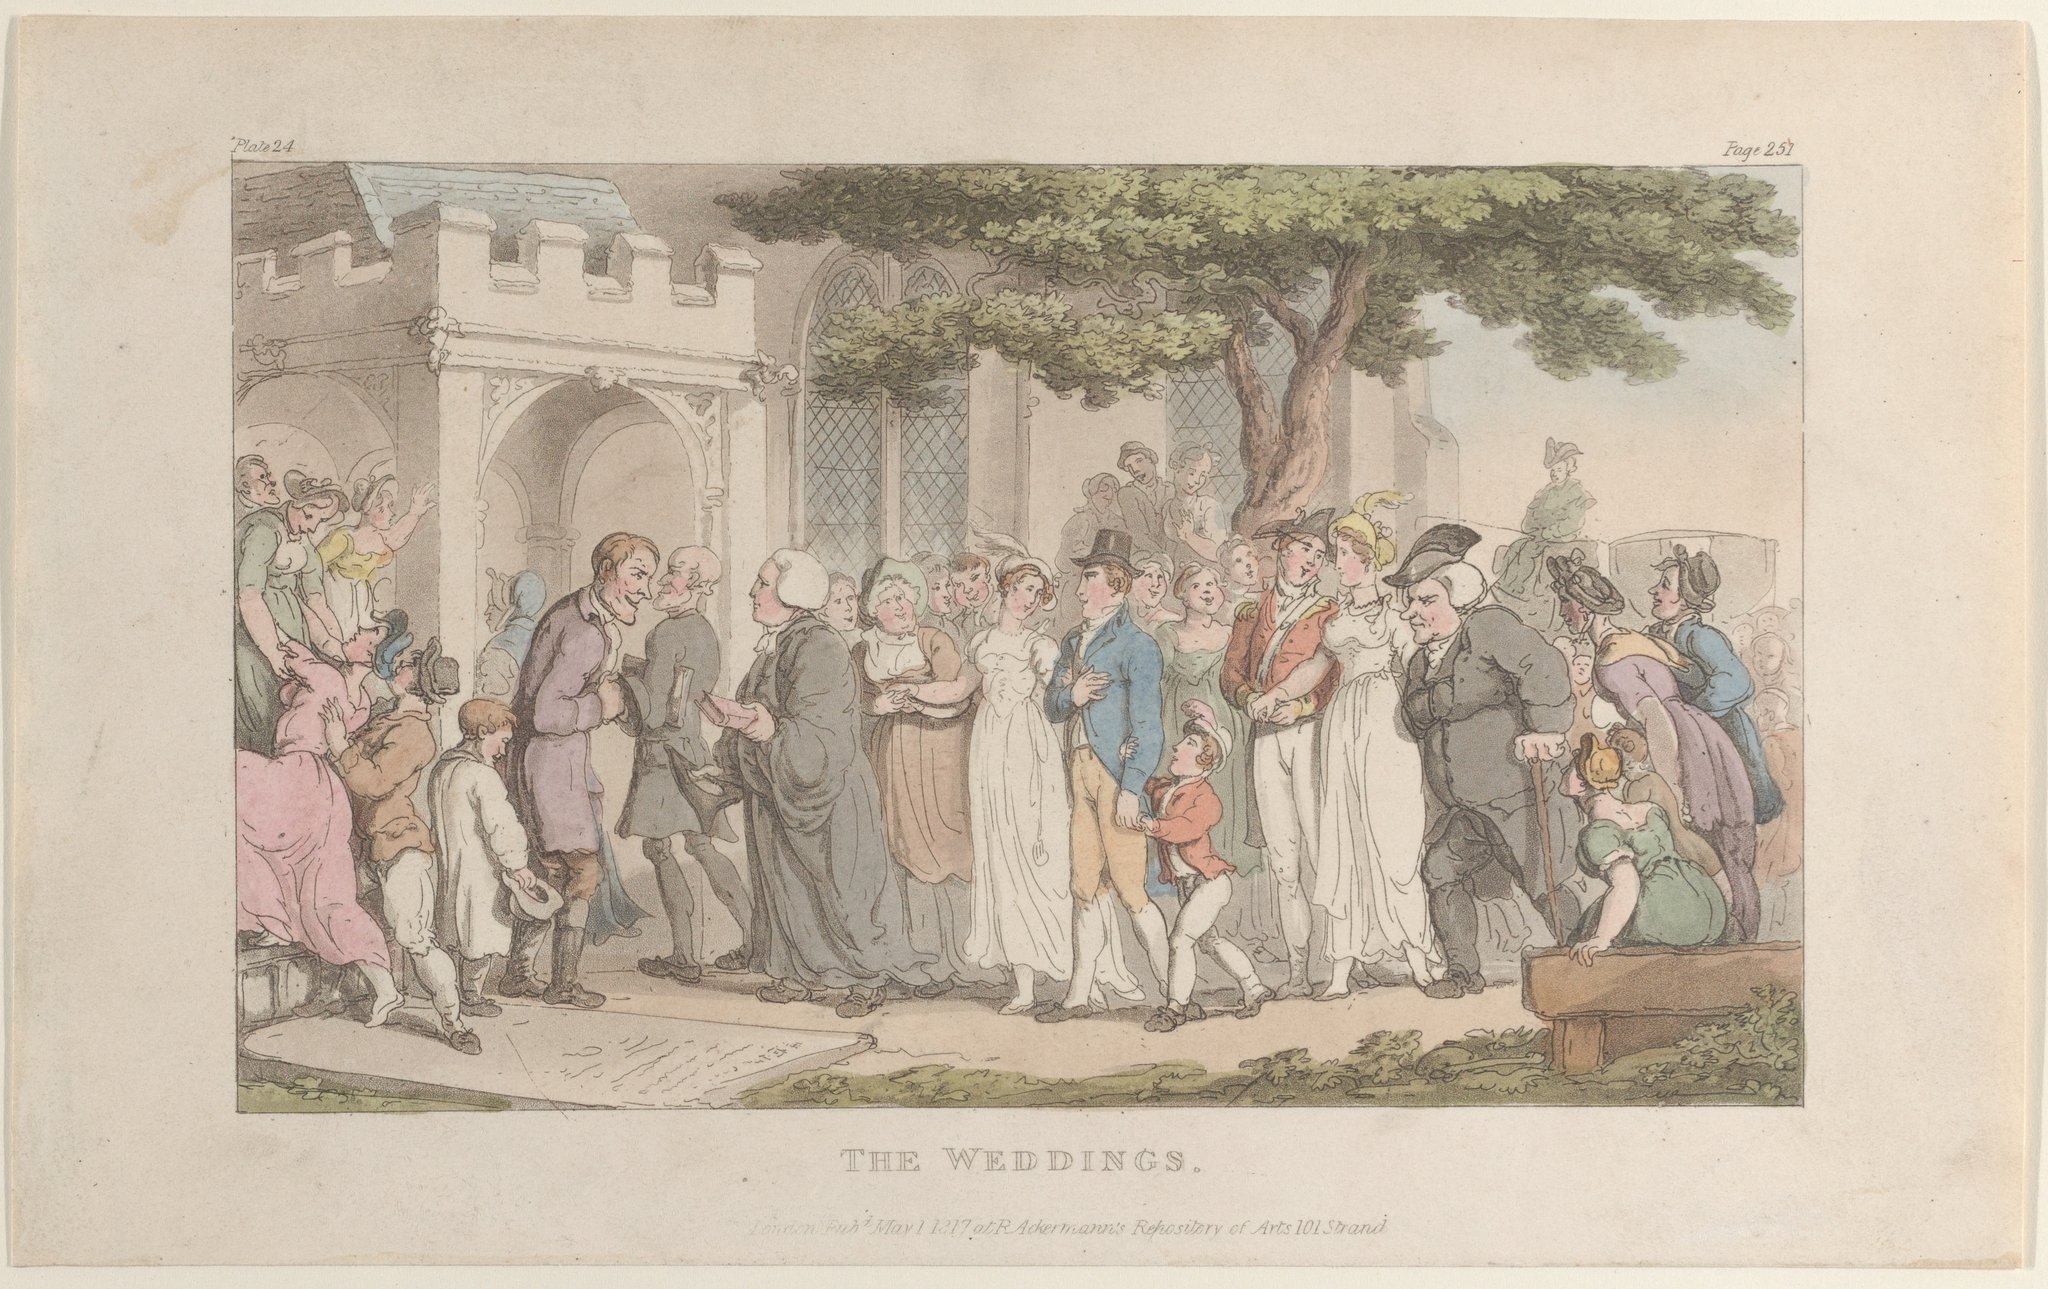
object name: print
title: The Weddings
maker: thomas rowlandson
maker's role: artist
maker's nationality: british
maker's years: 1757-1827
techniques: aquatint, etching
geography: london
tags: men,women,weddings